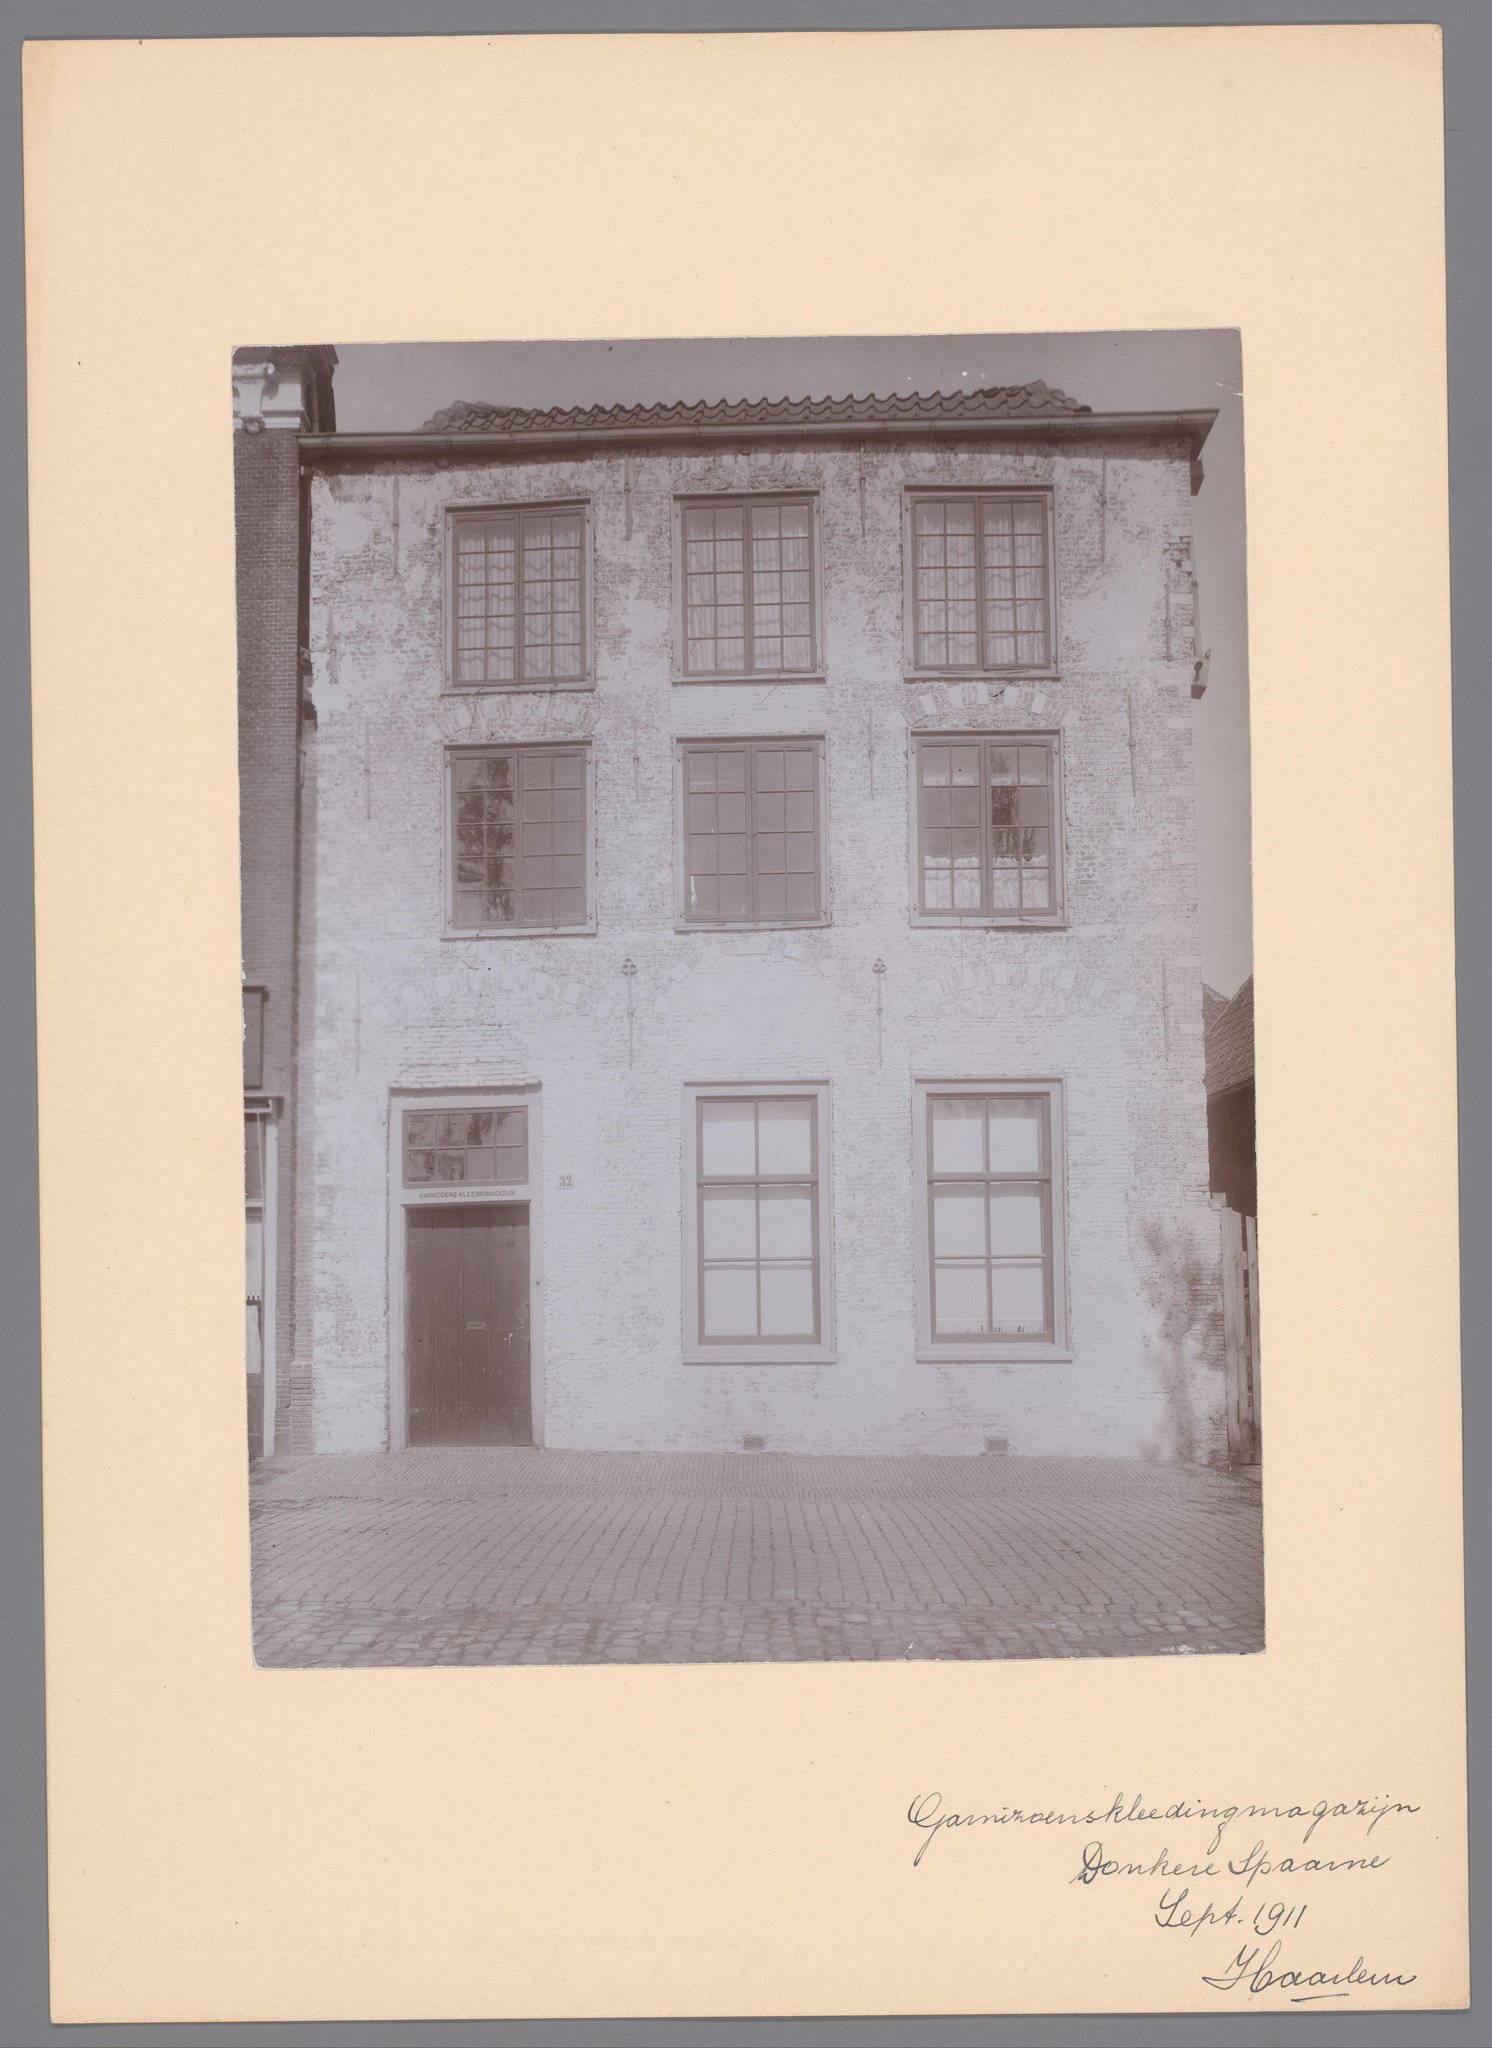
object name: photograph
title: Garnizoenen Kledingmagazijn aan het Donkere Spaarne te Haarlem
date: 1911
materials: cardboard, photographic support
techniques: collodion silver print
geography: donkere spaarne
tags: civic architecture; edifices; dwellings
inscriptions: annotation: ‘Garnizoenskleedingmagazijn/ Donkere Spaarne/ Sept. 1911/ Haarlem’